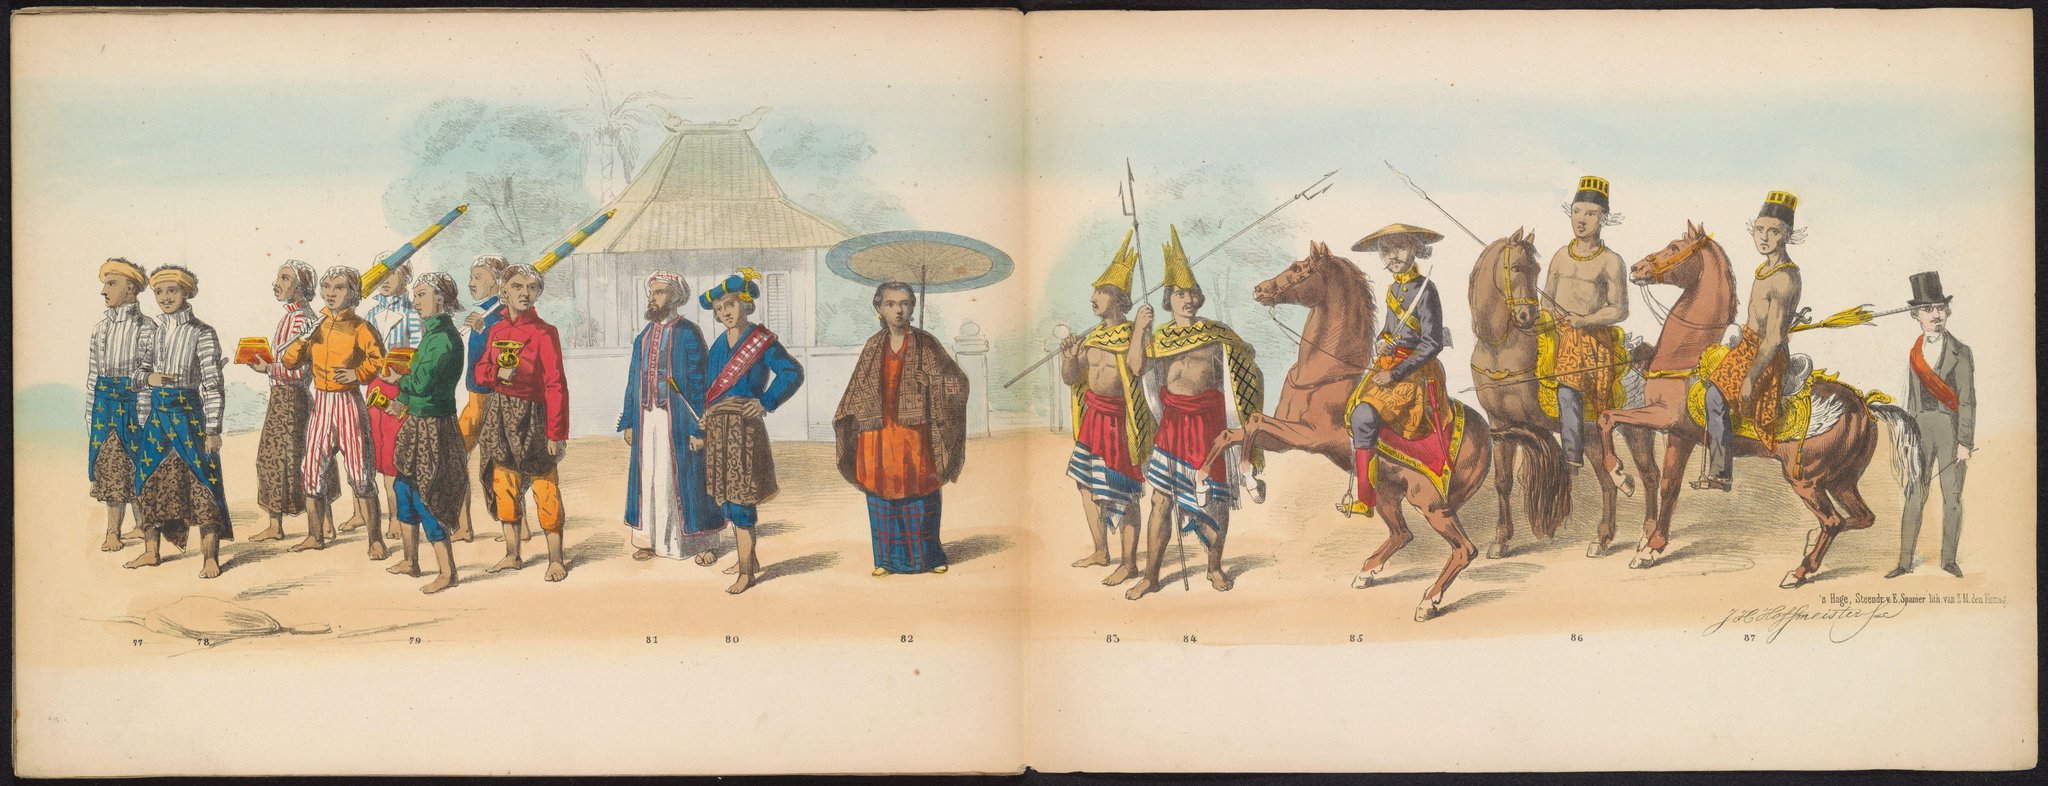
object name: print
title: Gecostumeerde optogt gehouden door de leden van het Delftsche studenten-corps den 5den Mei 1857, voorstellende den Garebeg optogt van den Sultan van Djokjokarta en de meest karakteristieke typen uit den Nederlandsch-Indischen Archipel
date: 1857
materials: paper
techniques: hand coloring, lithograph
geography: the hague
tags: students' pageant, costumes used in pageants, delft, dutch east indies, the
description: Gekostumeerde optocht van de studenten van de Koninklijke Akademie te Delft op 5 mei 1857. De optocht verbeeldt de Garebeg optocht van de sultan van Djokjakarta plus verschillende karakteristieke types uit de Indonesische archipel. Negende plaat met de groepen genummerd 77-87. Onderdeel van de serie van acht en een half aanelkaar geplakte bladen.